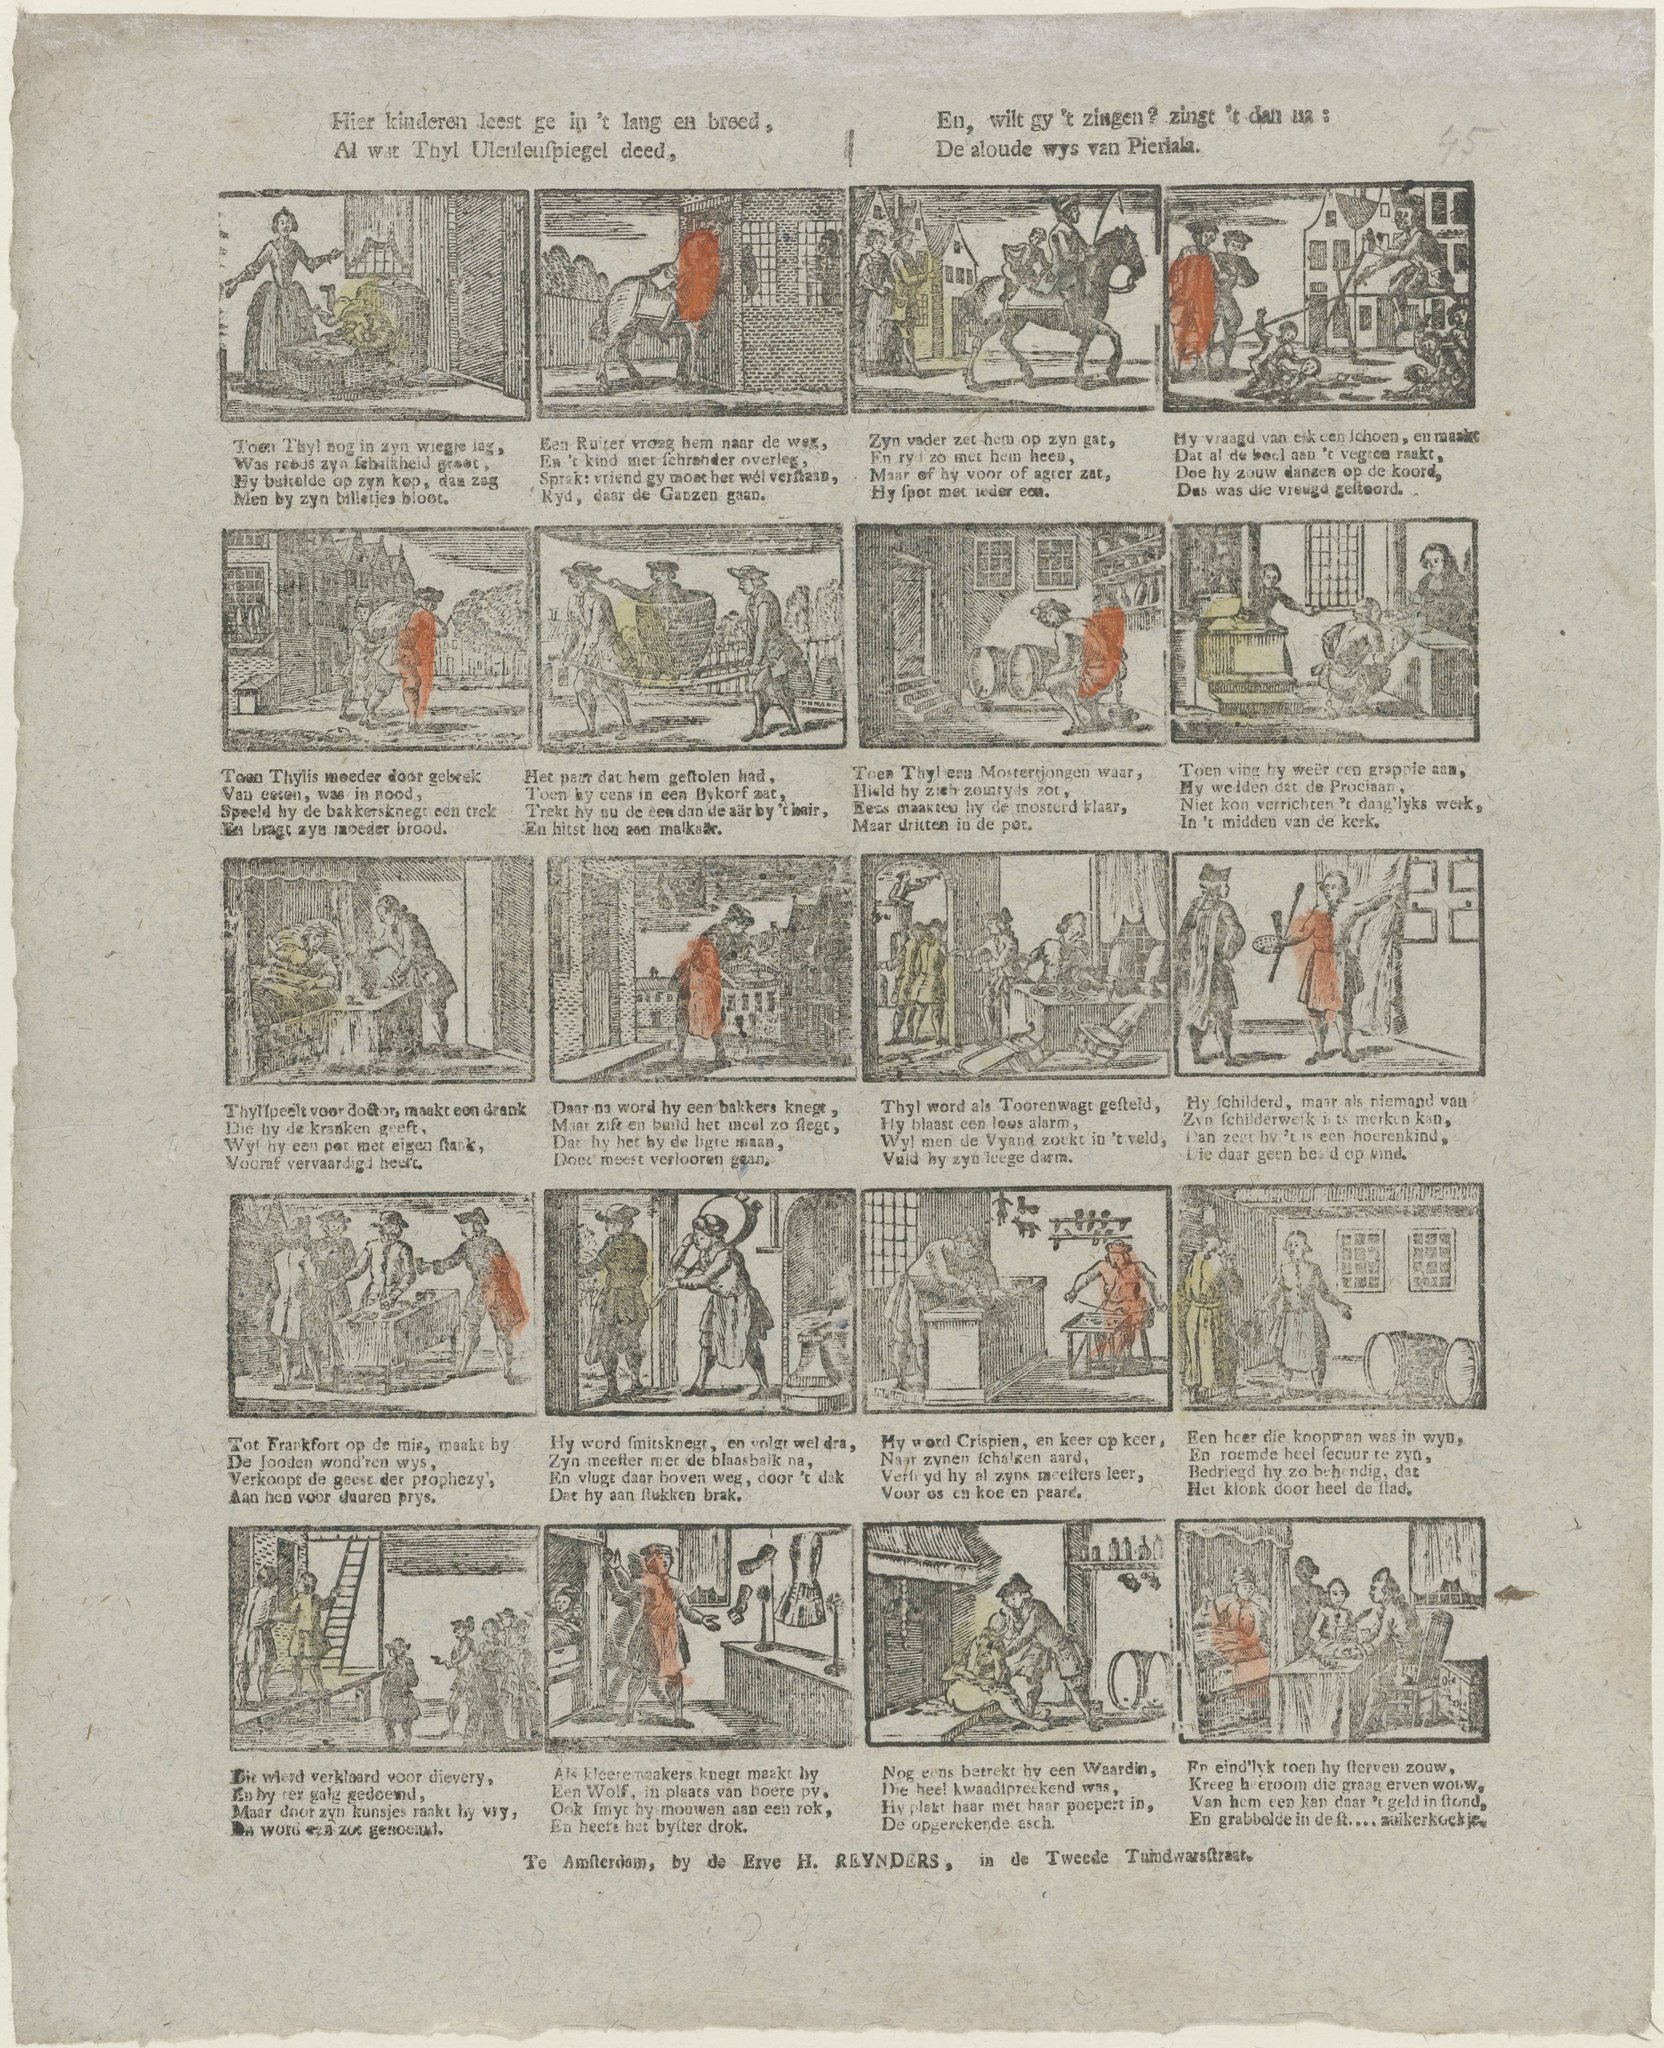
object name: print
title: Hier kinderen leest ge in 't lang en breed, / Al wat Thyl Ulenspiegel deed, / En, wilt gy 't zingen? zin 't dan na: / De aloude wys van Pierlala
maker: Anonymous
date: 1831-1854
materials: paper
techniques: colour, letterpress printing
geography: amsterdam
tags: eulenspiegel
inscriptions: collector's mark: Lugt 2760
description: Blad met 20 voorstellingen over het leven van Tijl Uilenspiegel. Onder elke afbeelding een vierregelig vers.